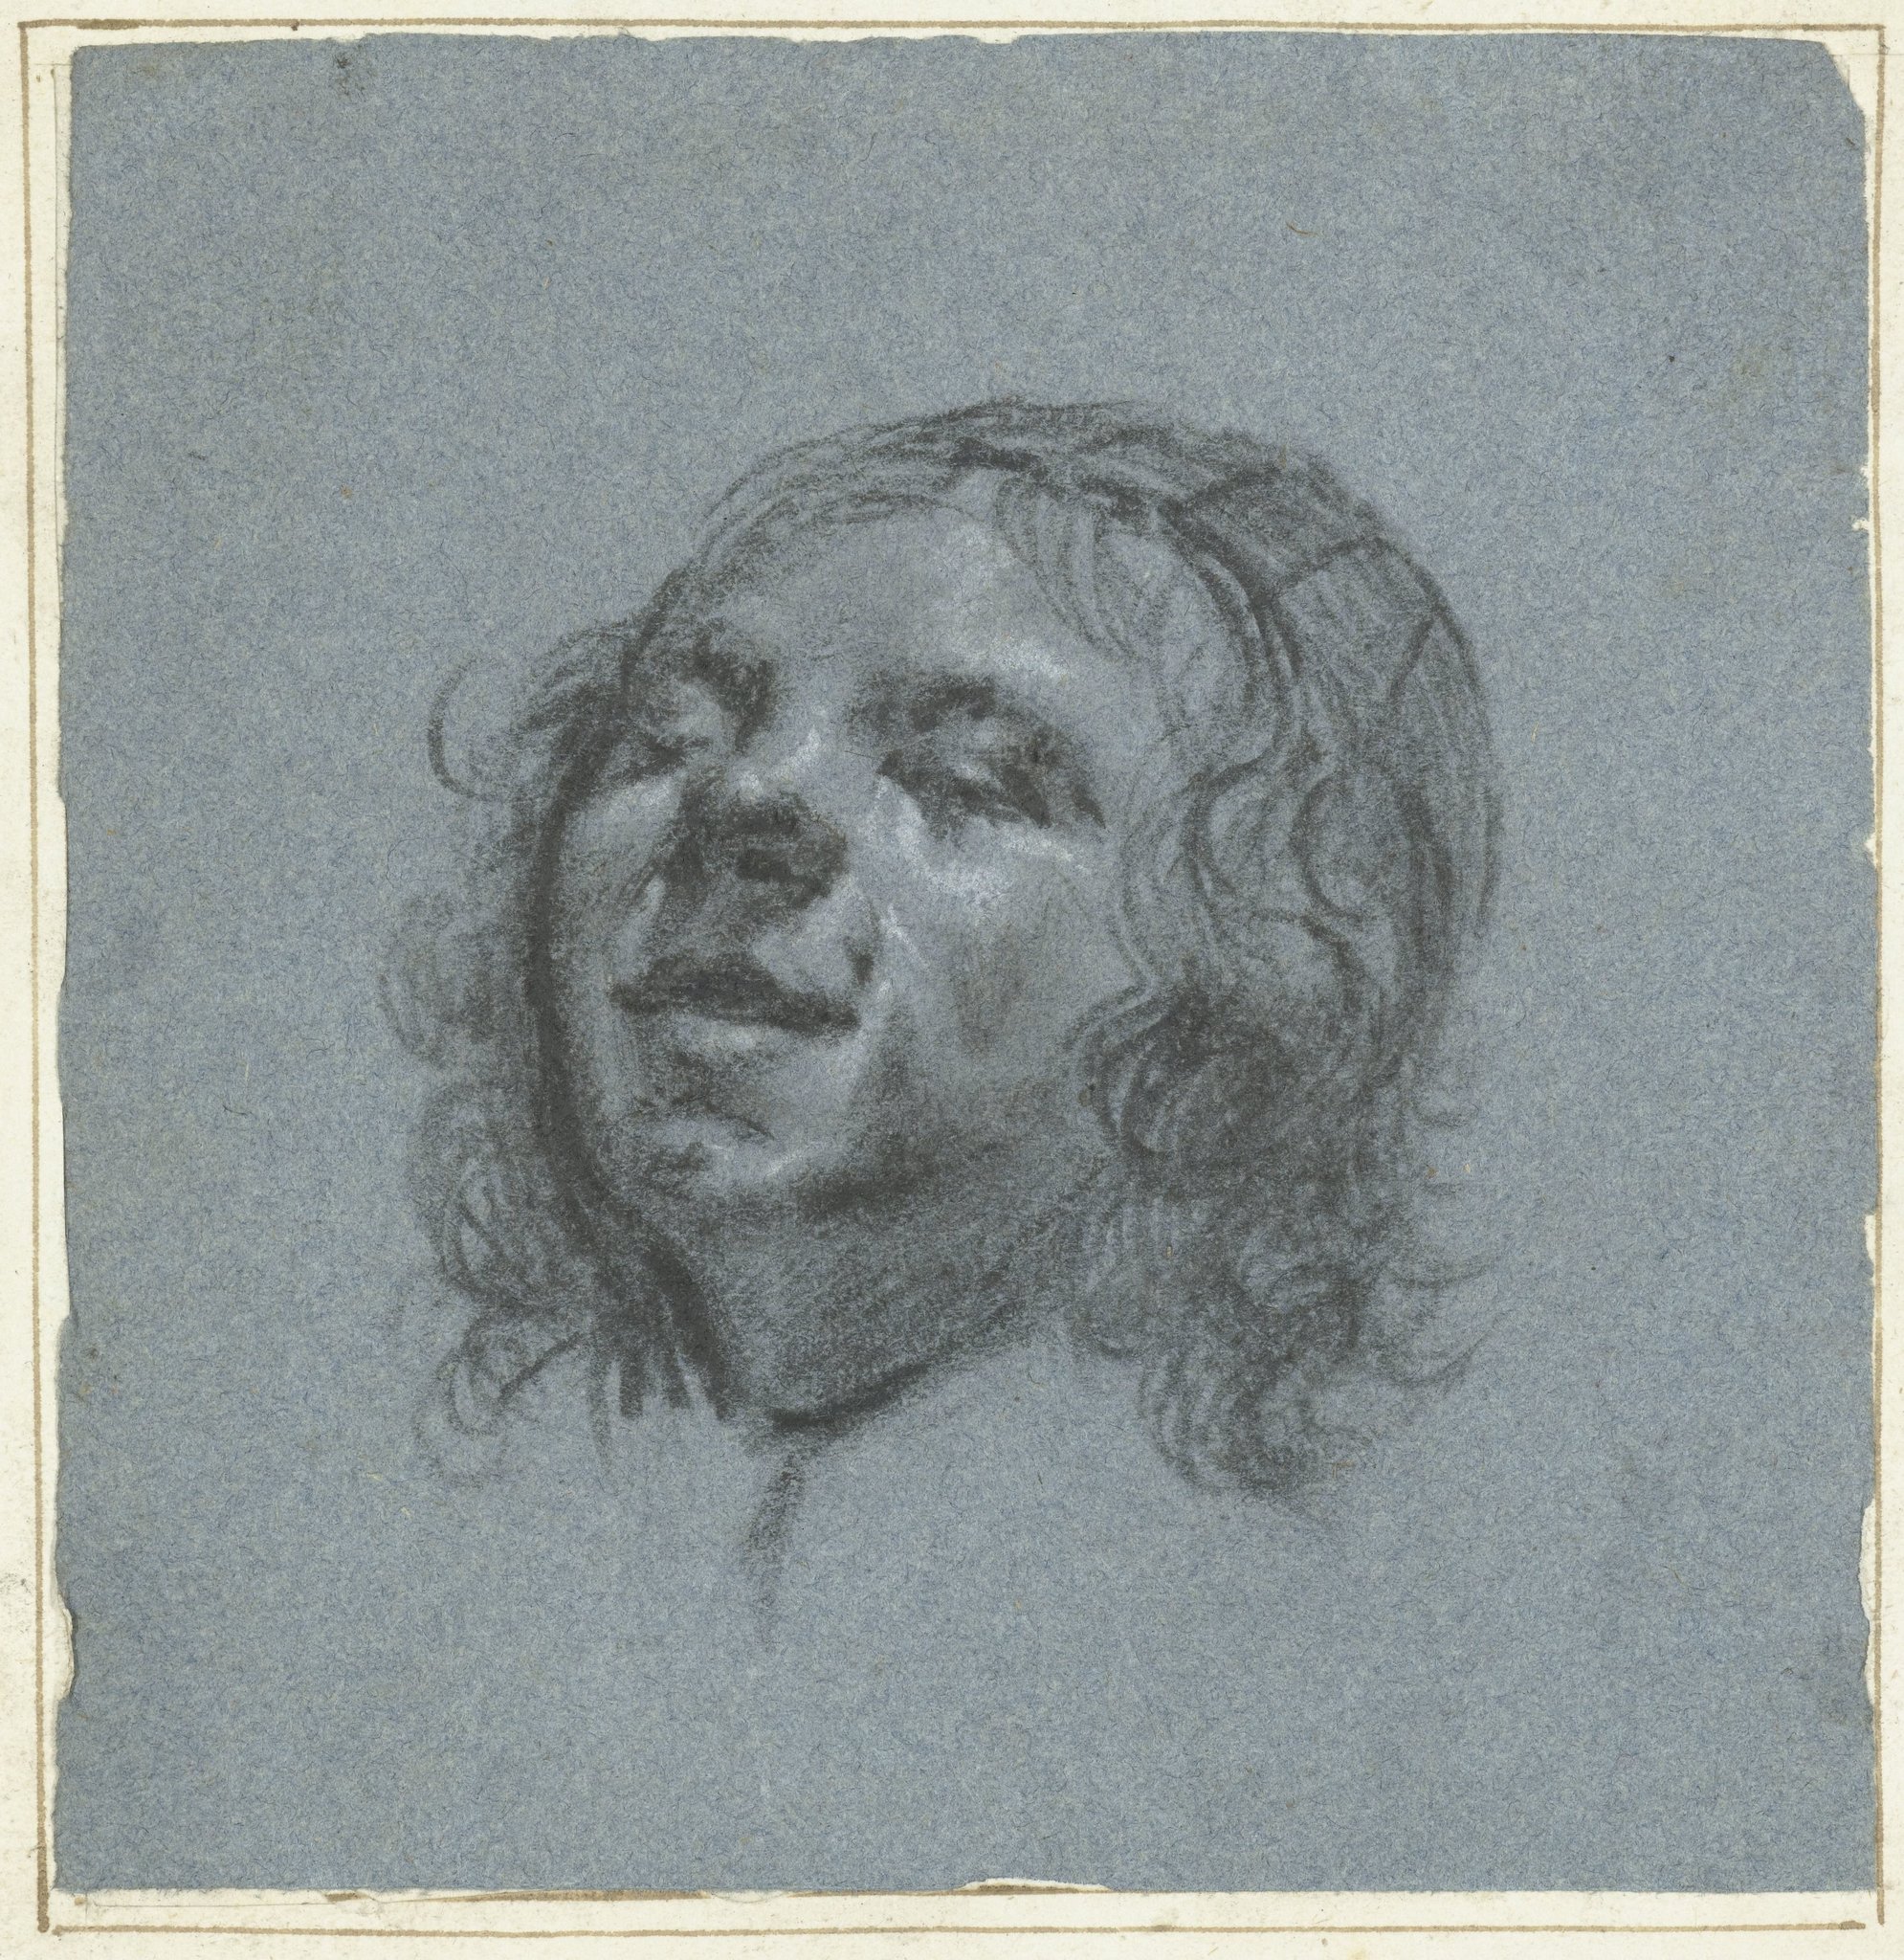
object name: drawing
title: Zelfportret van Moses ter Borch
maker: moses ter borch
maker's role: draughtsman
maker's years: 1645-1667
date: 1660-1661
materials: chalk, ink, paper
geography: zwolle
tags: draughtsman, moses ter borch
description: Tekening is samen met een andere tekening op een blad geplakt.